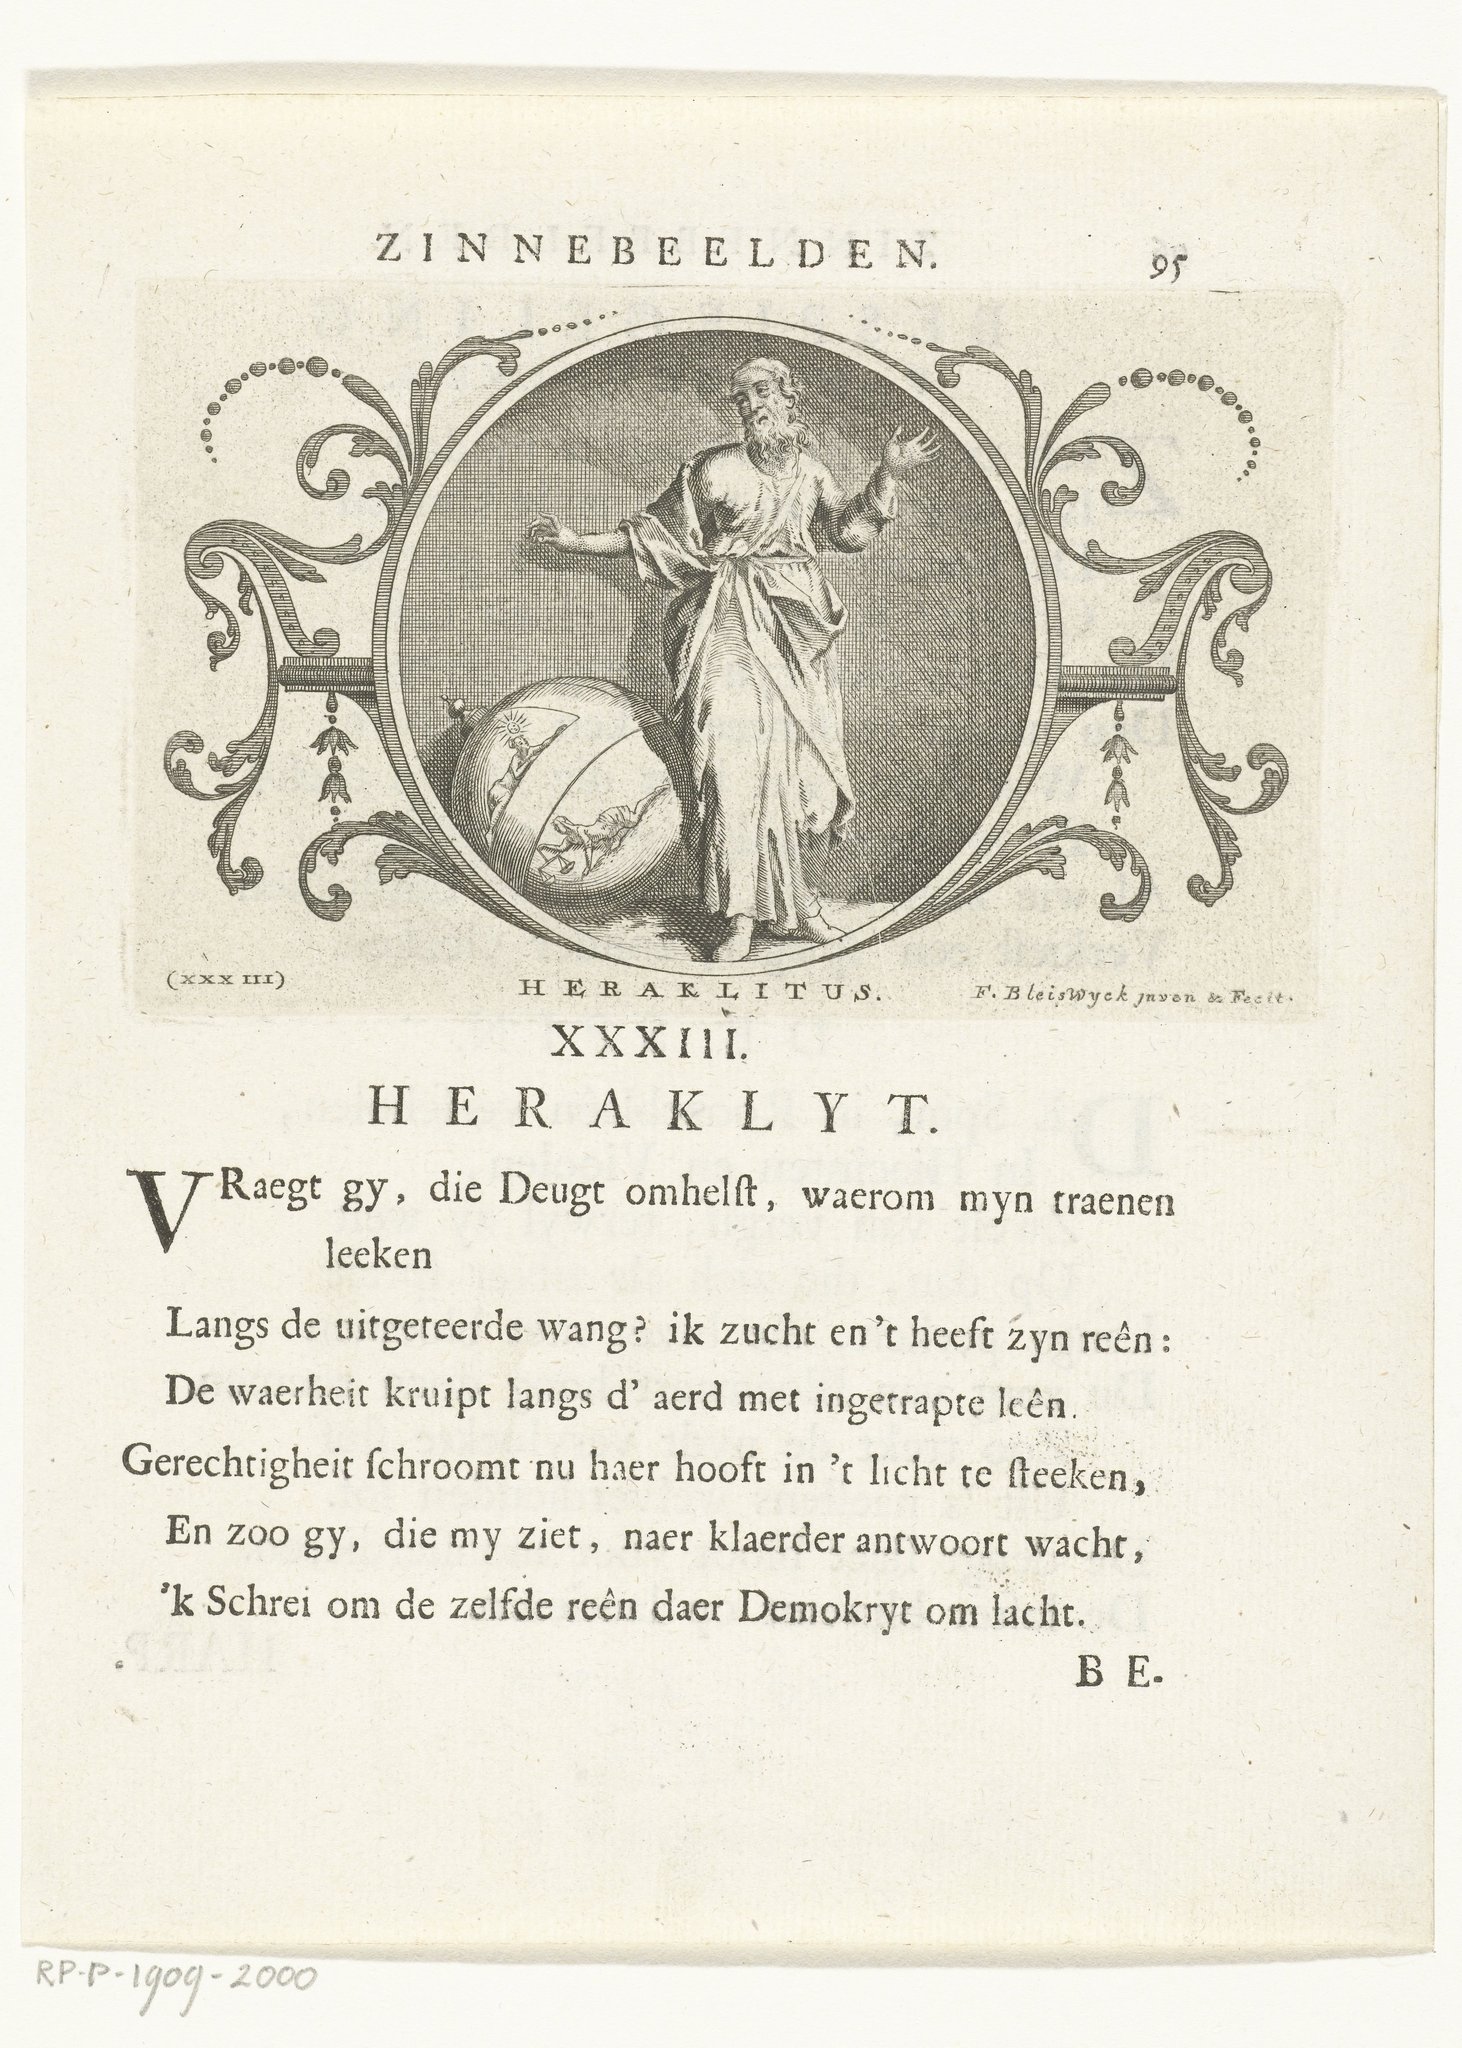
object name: book illustration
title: Heraklitus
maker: françois van bleyswijck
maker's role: draughtsman, print maker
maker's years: 1671-1746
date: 1681-1737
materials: paper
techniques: etching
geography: leiden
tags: heraclitus, the weeping philosopher, and democritus, the laughing philosopher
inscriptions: collector's mark: Lugt 2228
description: Embleem met filosoof Heraclitus die huilend naast wereldbol staat waarop vrouwelijke personificaties van gerechtigheid en waarheid verslagen rondkruipen. Onder de voorstelling staat een gedicht.